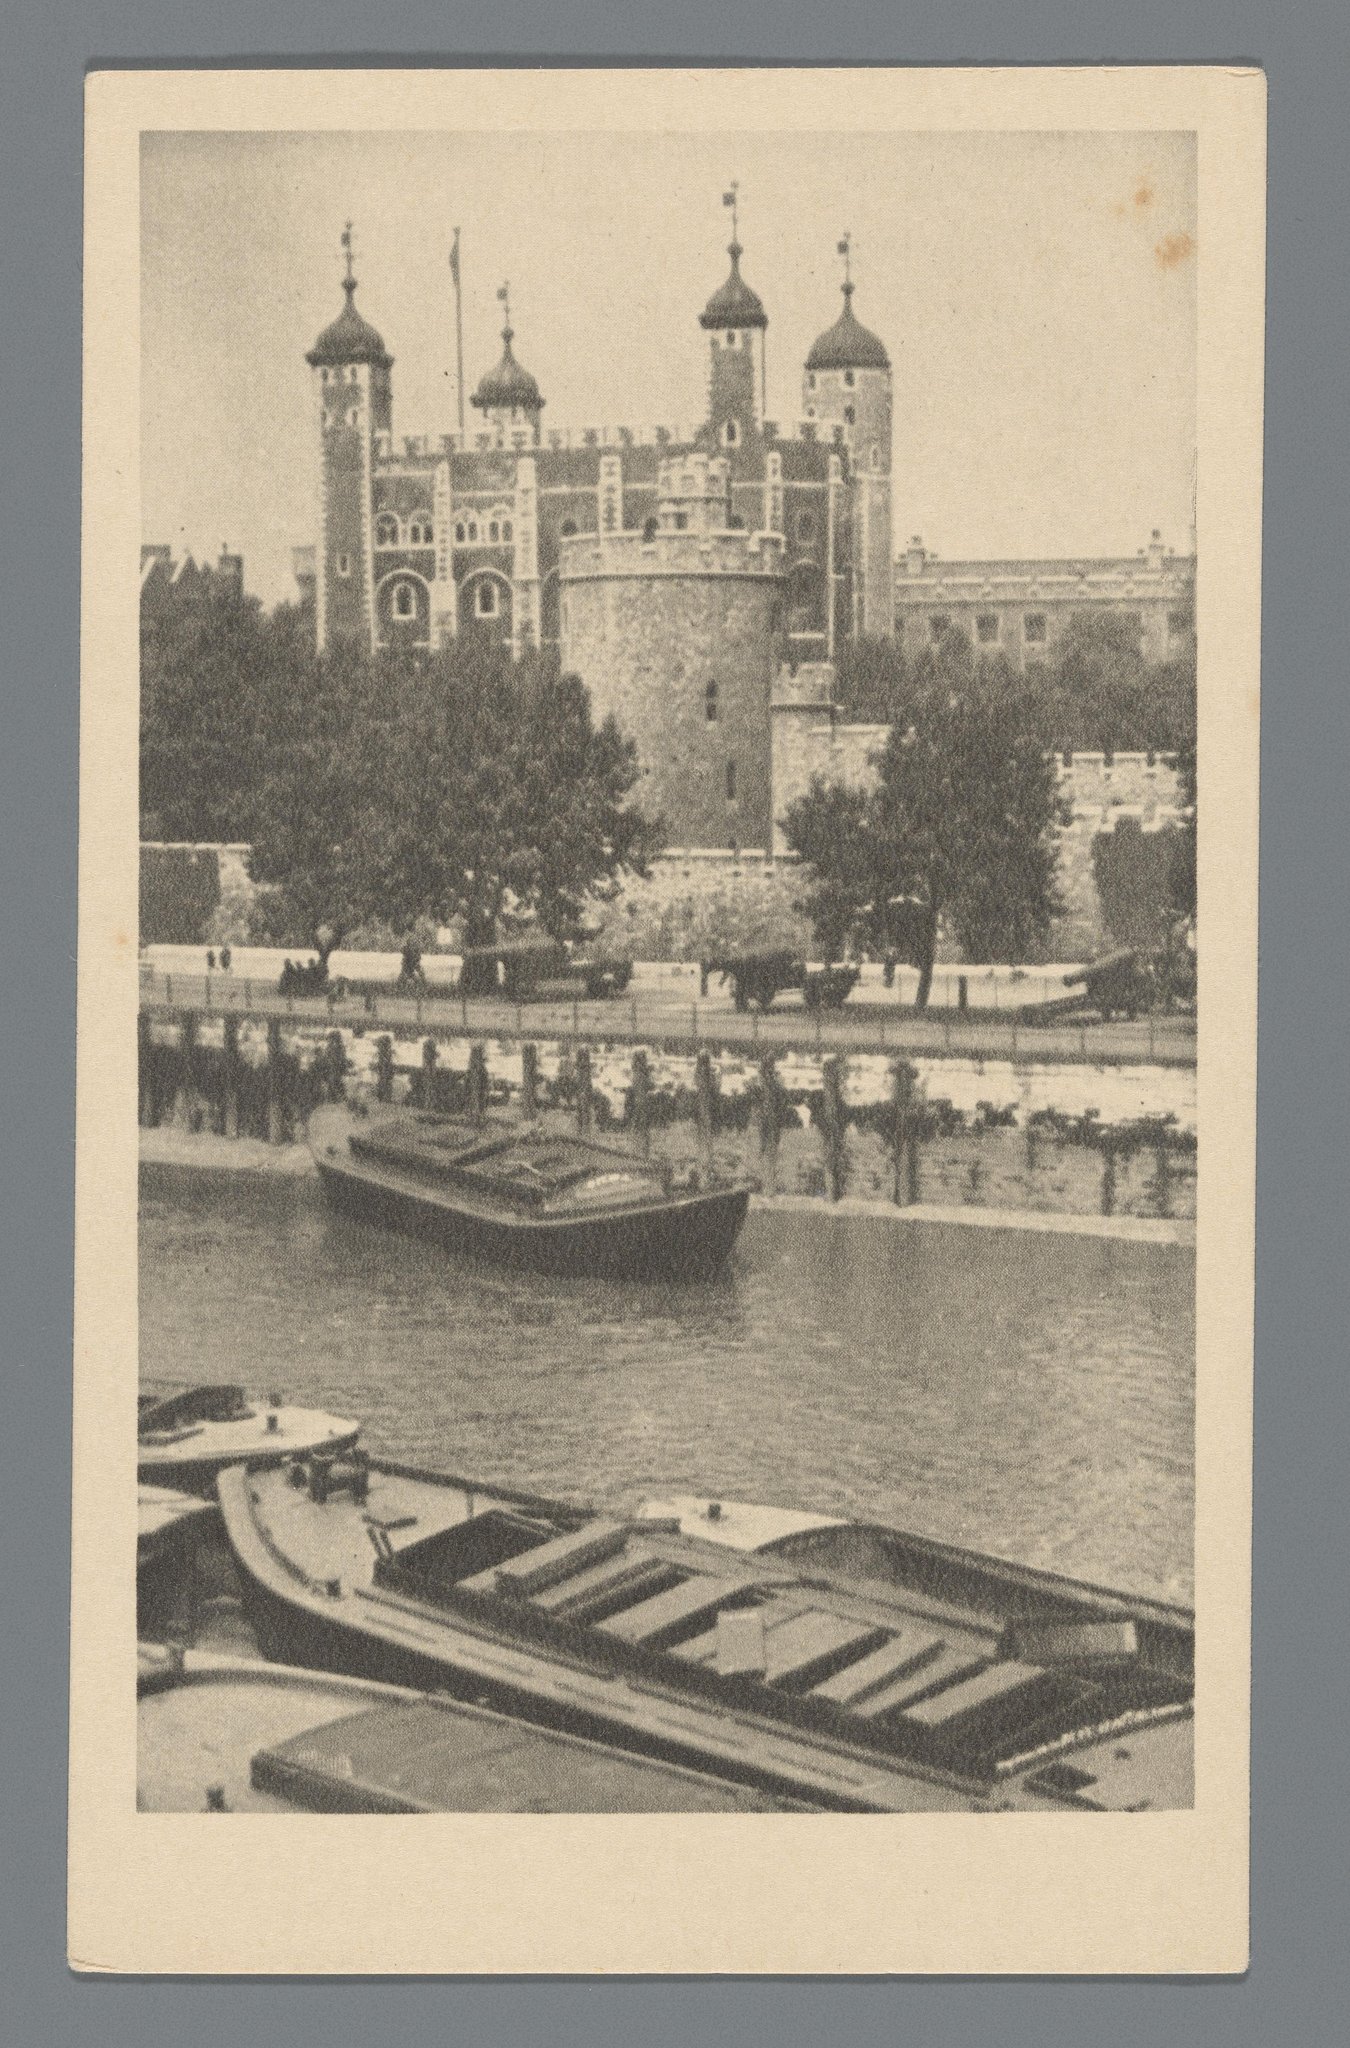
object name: photomechanical print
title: Gezicht op de Tower of London aan de Theems met boten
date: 1914-2024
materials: cardboard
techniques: photoaquatint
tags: castle, river, tow-boat, towing-barge